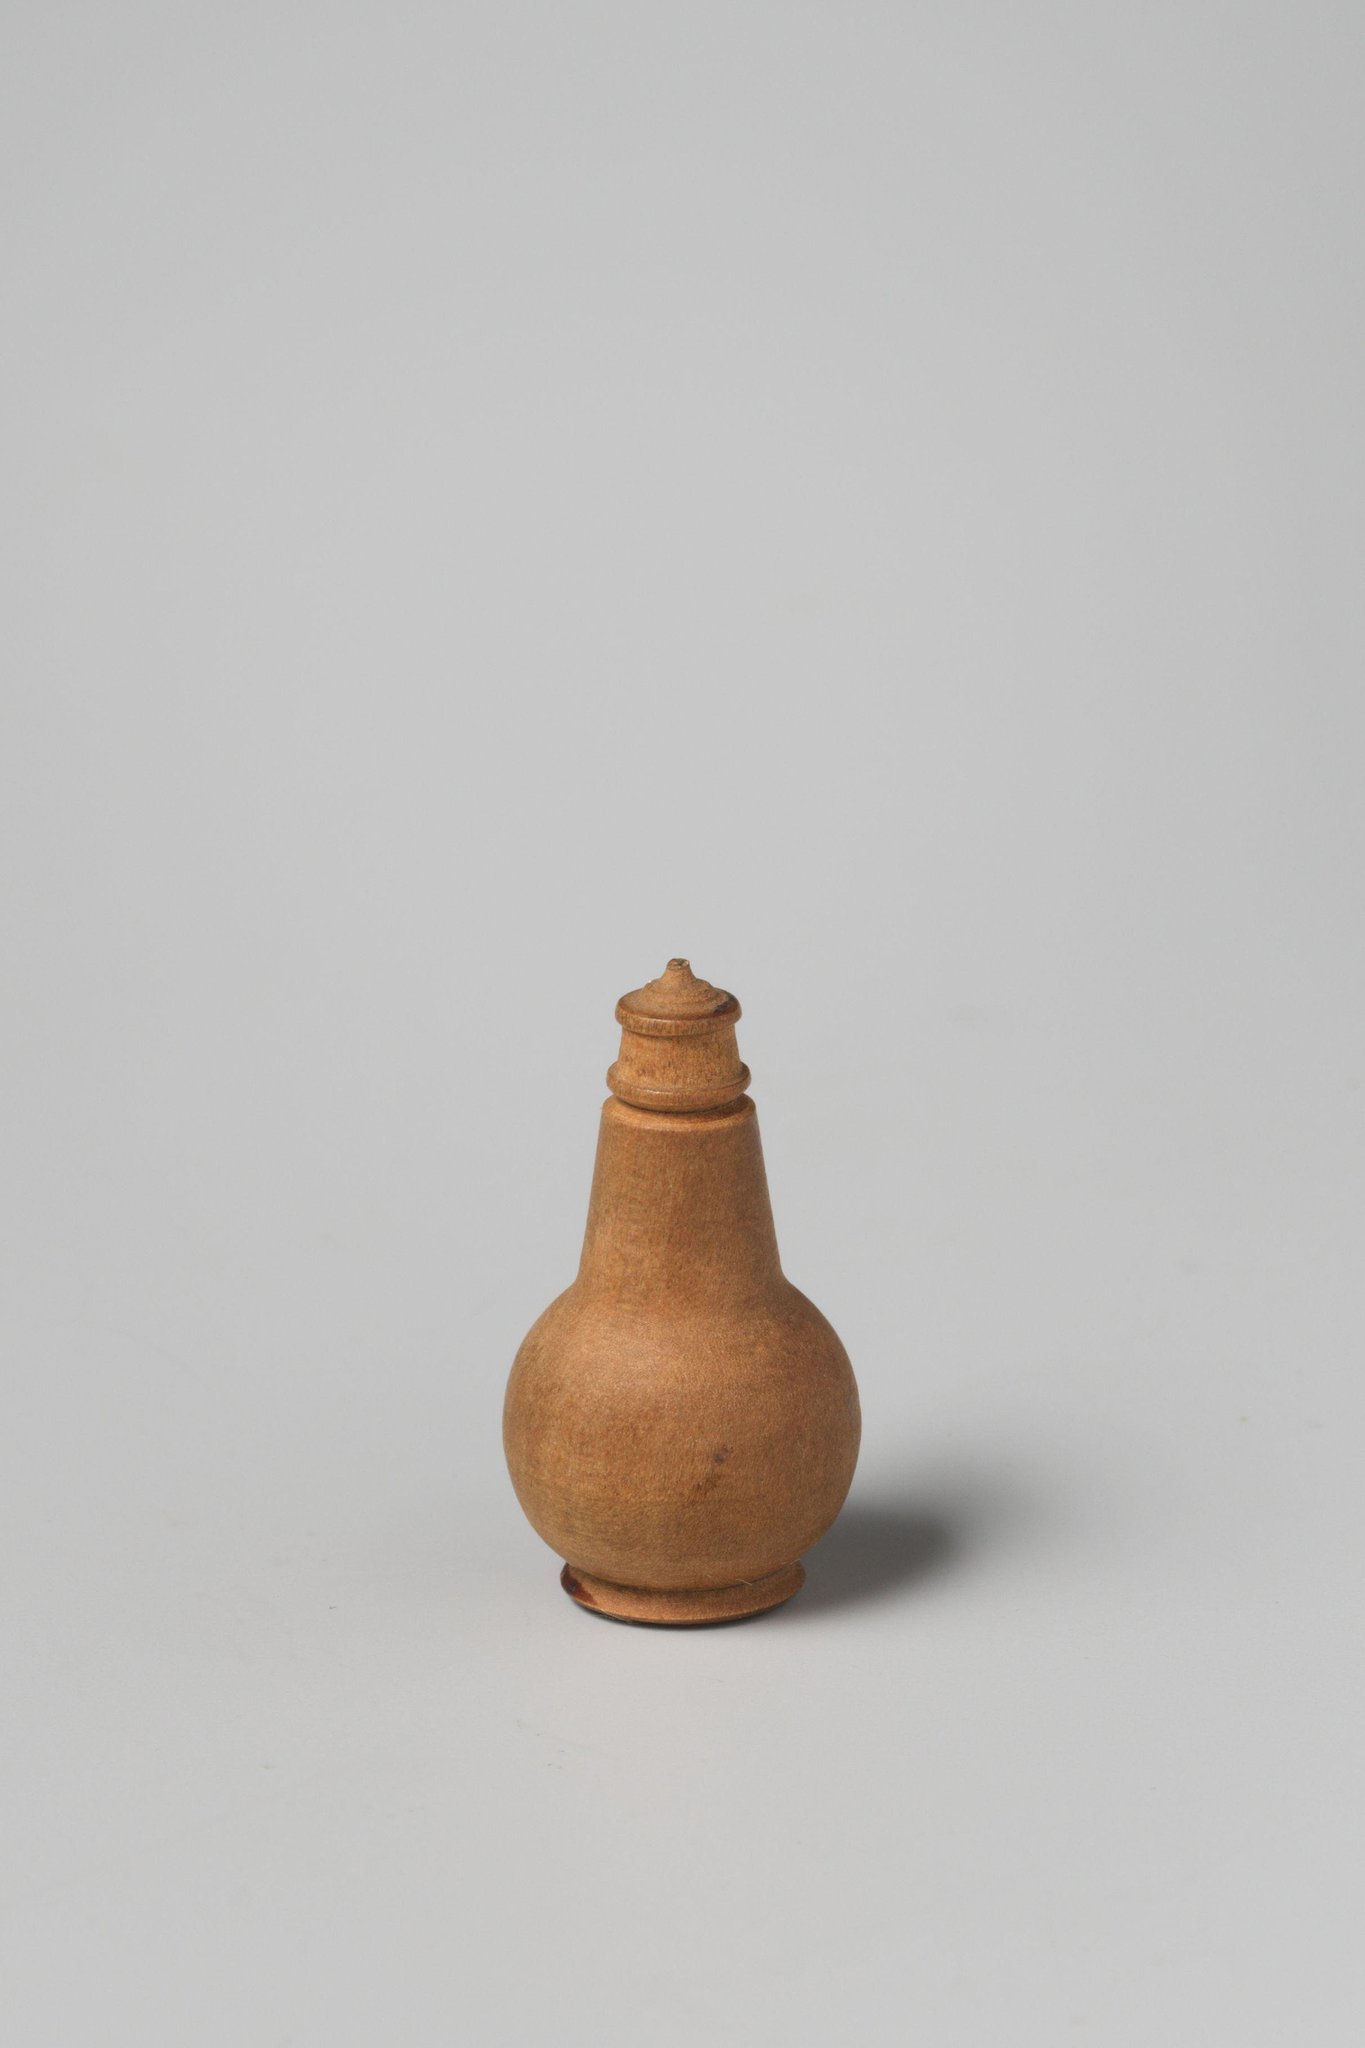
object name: miniature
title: Fles, gedraaid van esdoornhout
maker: Anonymous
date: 1675-1699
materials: wood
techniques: turning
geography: amsterdam